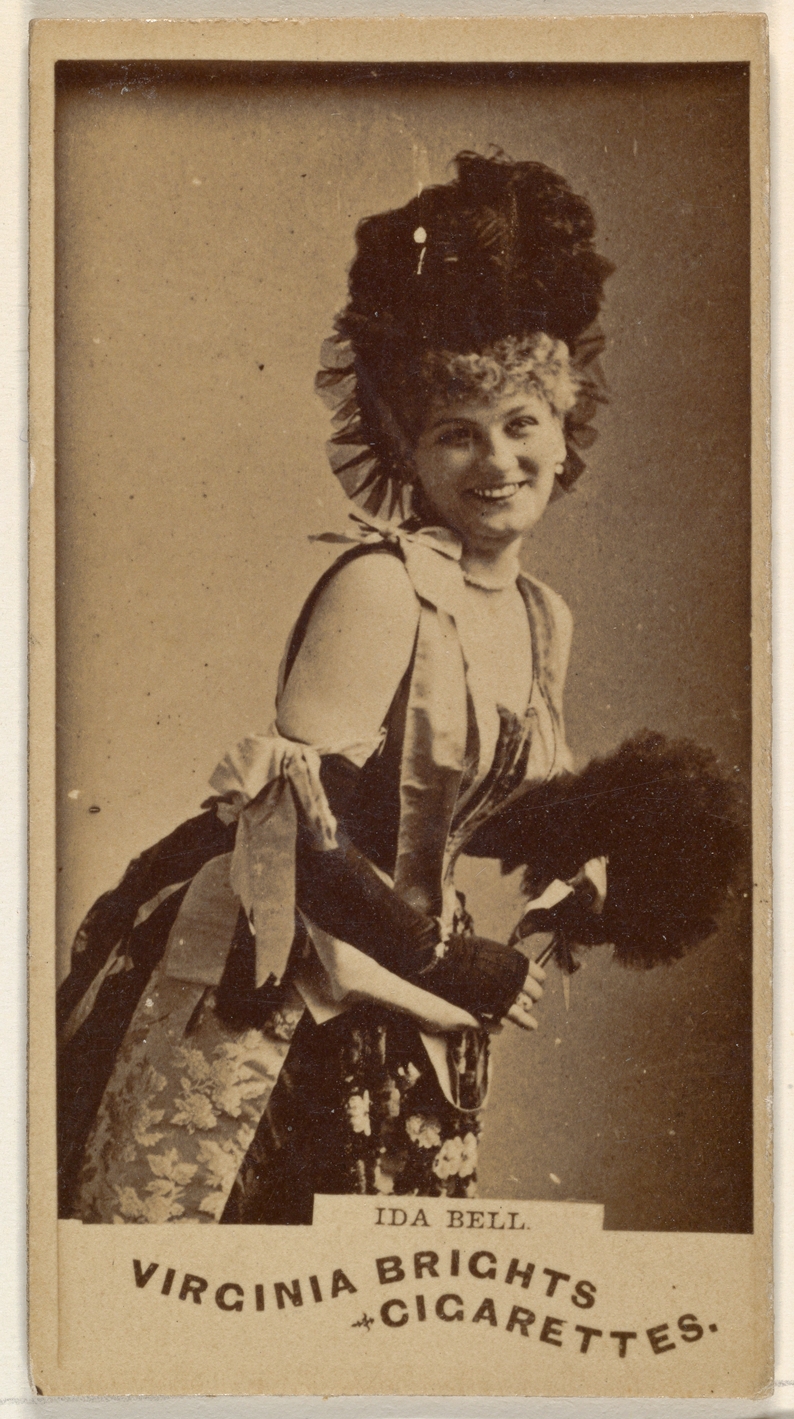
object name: photograph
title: Ida Bell, from the Actors and Actresses series (N45, Type 1) for Virginia Brights Cigarettes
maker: allen & ginter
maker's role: publisher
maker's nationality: american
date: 1888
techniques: albumen silver print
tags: portraits,women,actresses